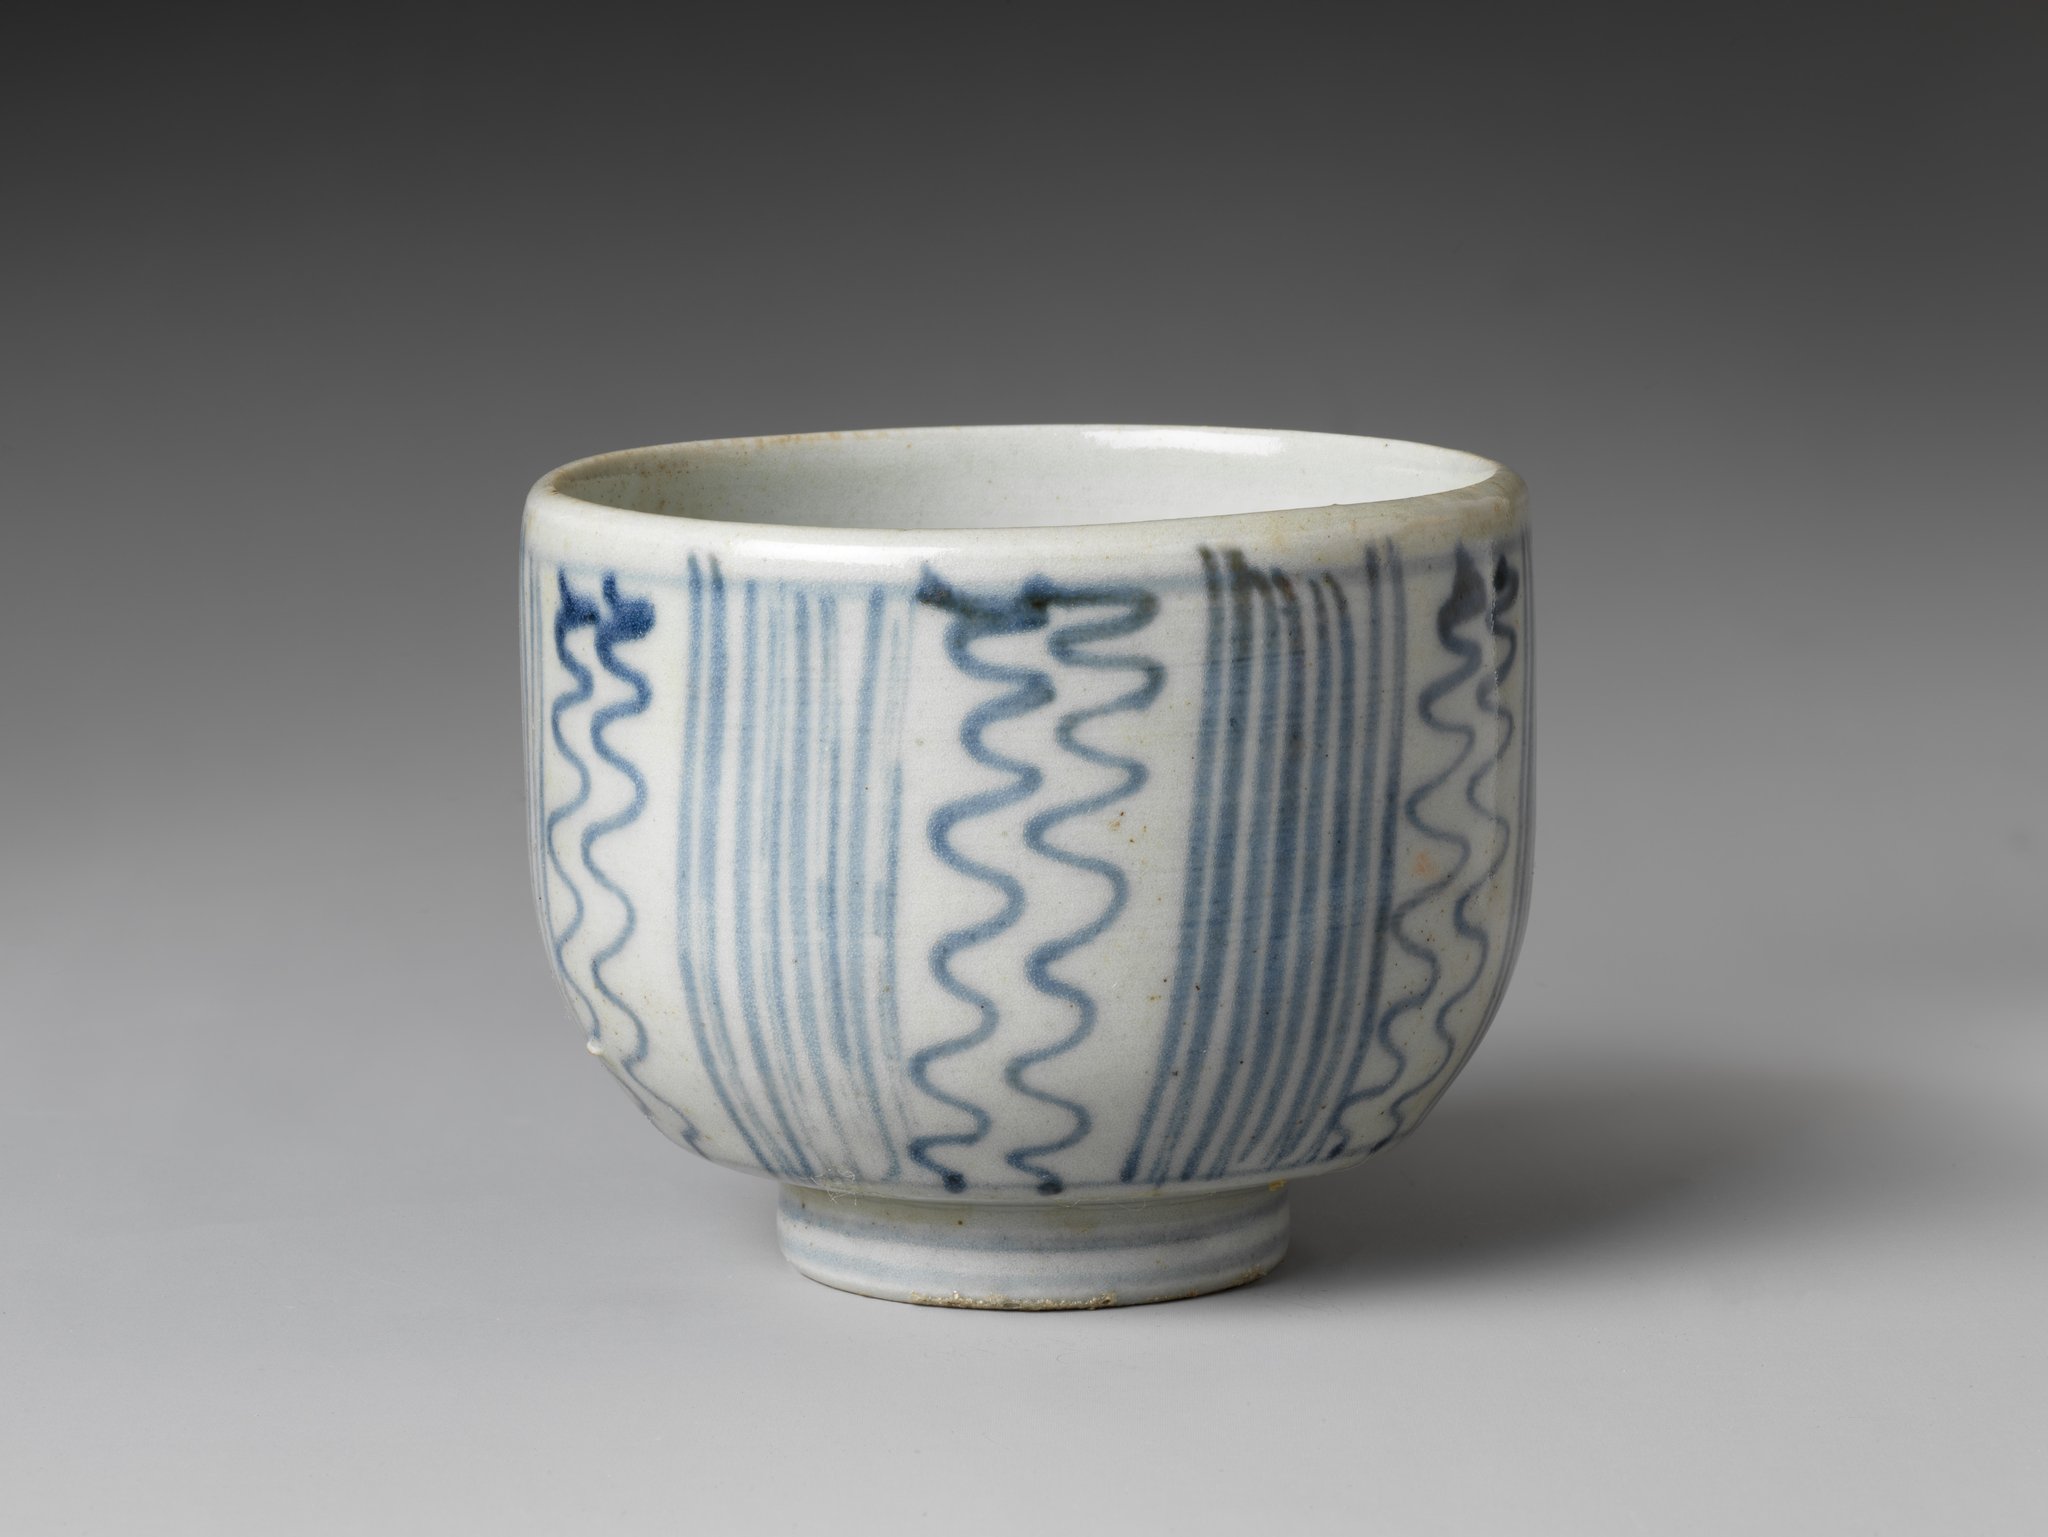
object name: soba cup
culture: japanese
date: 1615-1868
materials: porcelain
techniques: underglaze